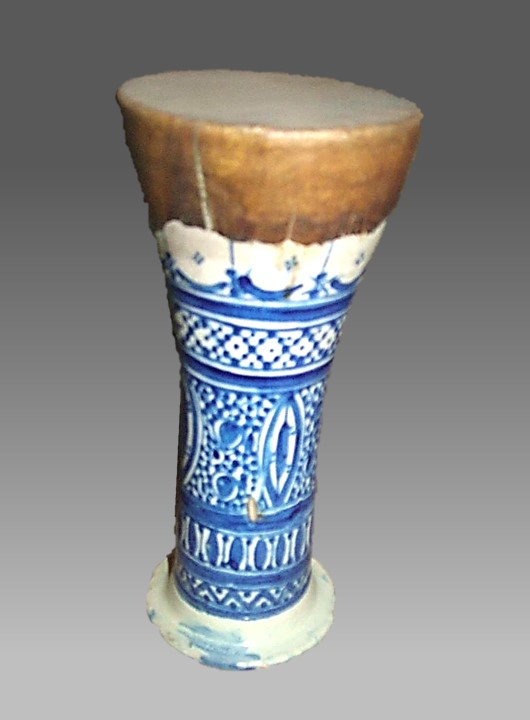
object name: t'arija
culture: moroccan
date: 1867-1900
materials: clay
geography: morocco